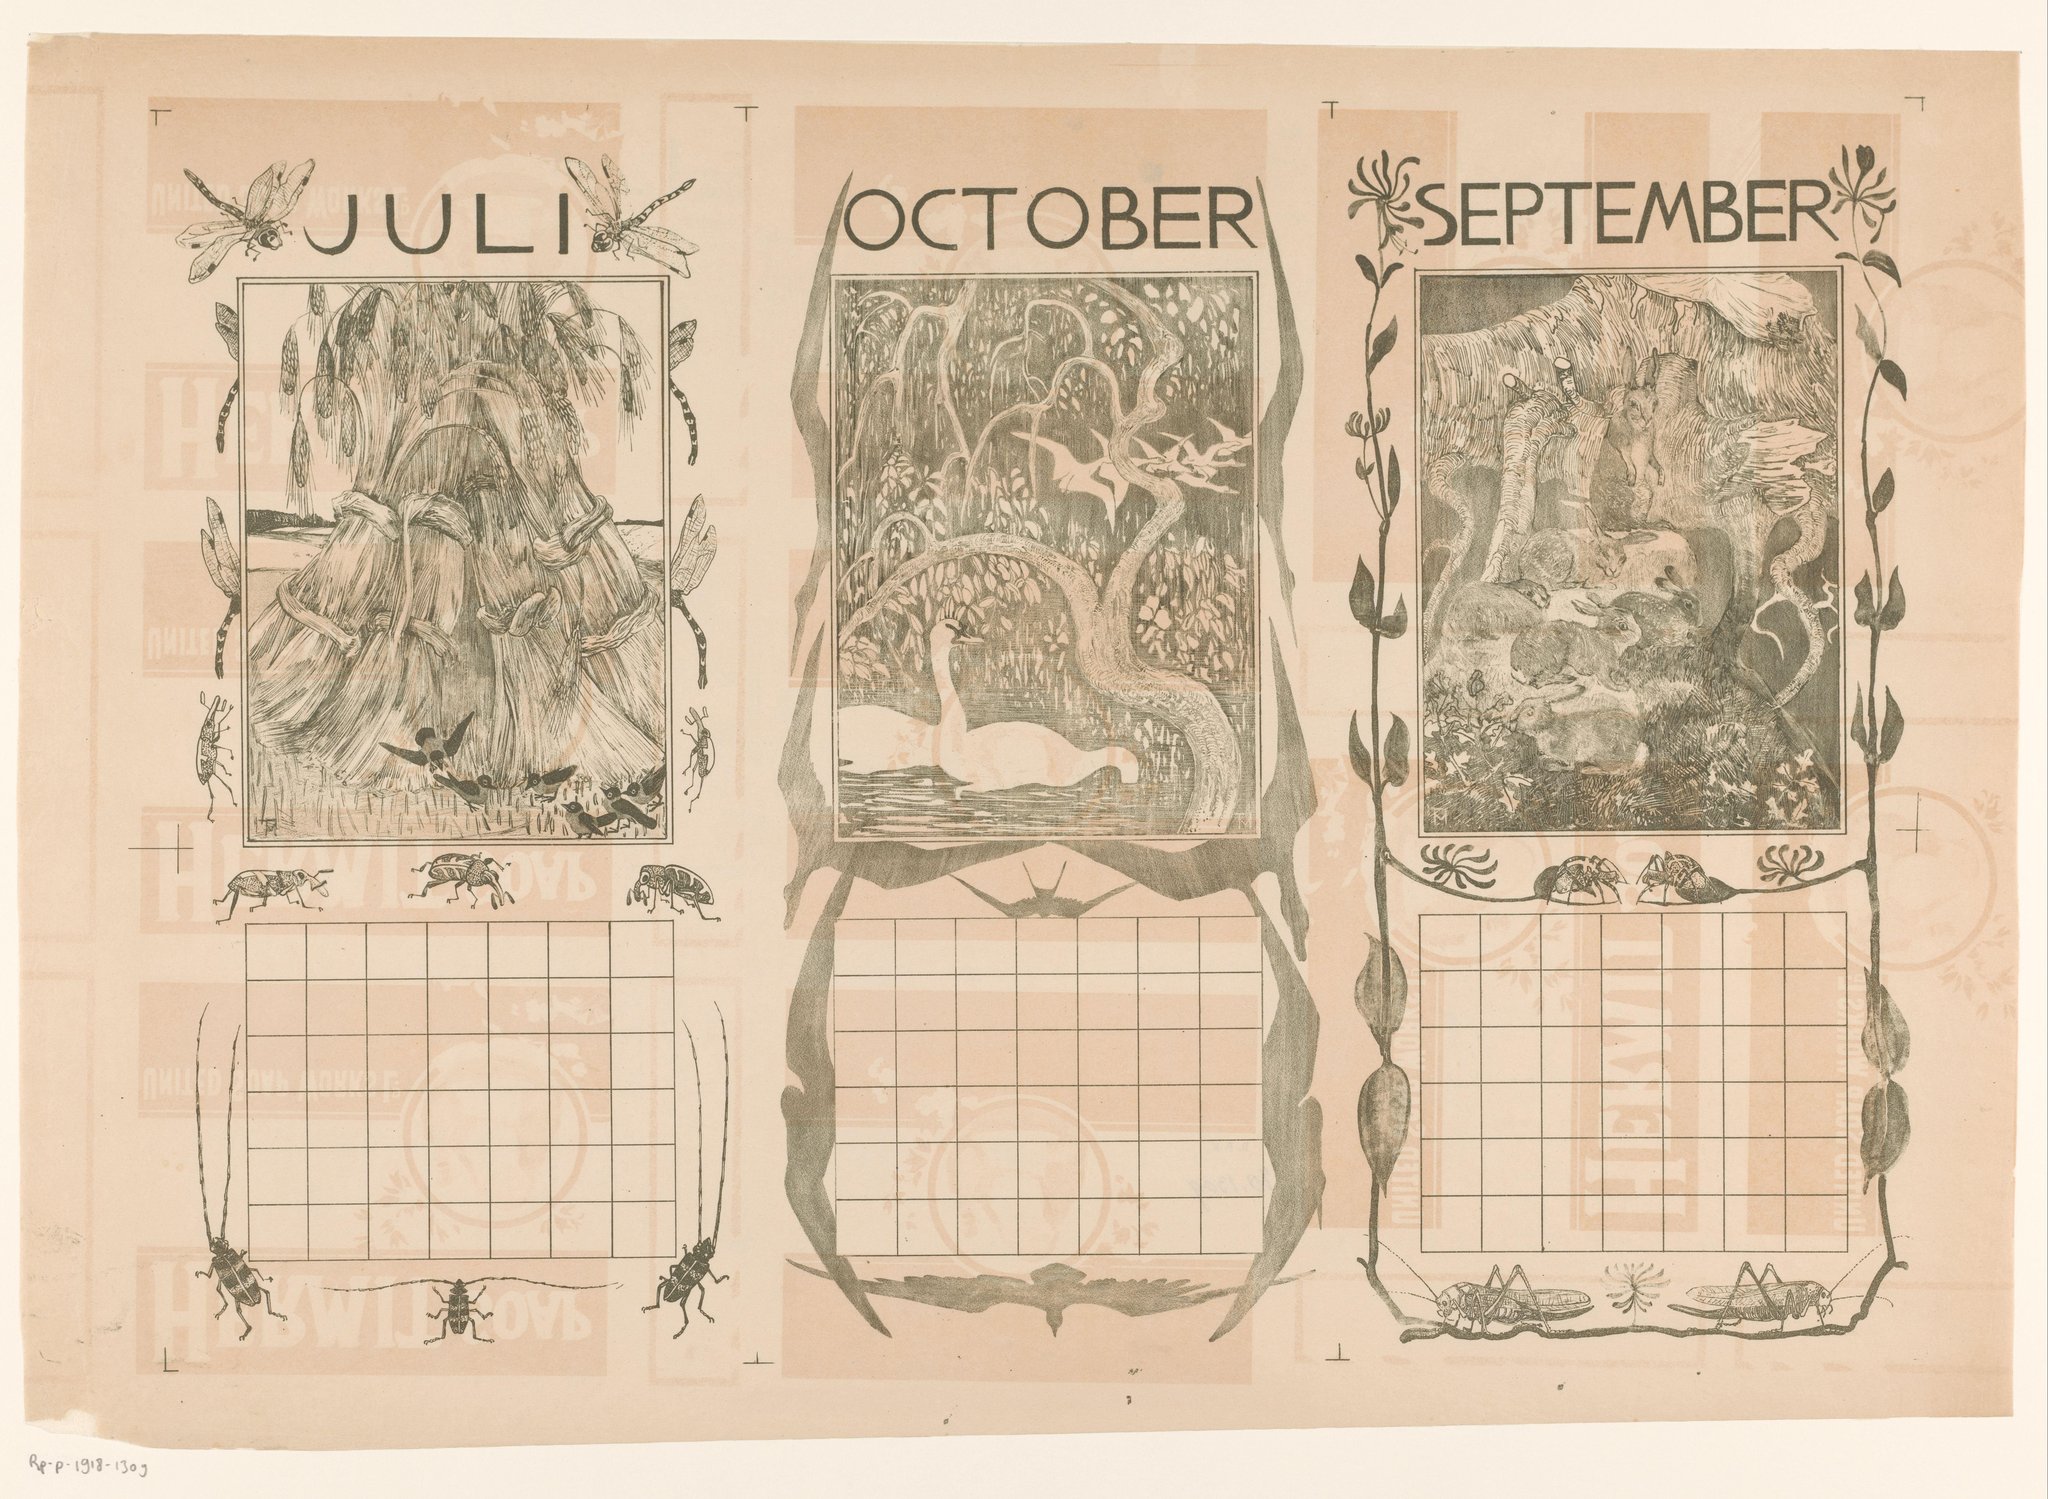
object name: calendar leaf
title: Kalenderbladen van april, mei en juni, met hagedis en vogels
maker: theo van hoytema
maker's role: draughtsman, painter, print maker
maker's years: 1863-1917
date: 1901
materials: paper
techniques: lithograph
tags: calendar, almanac, lizards, birds